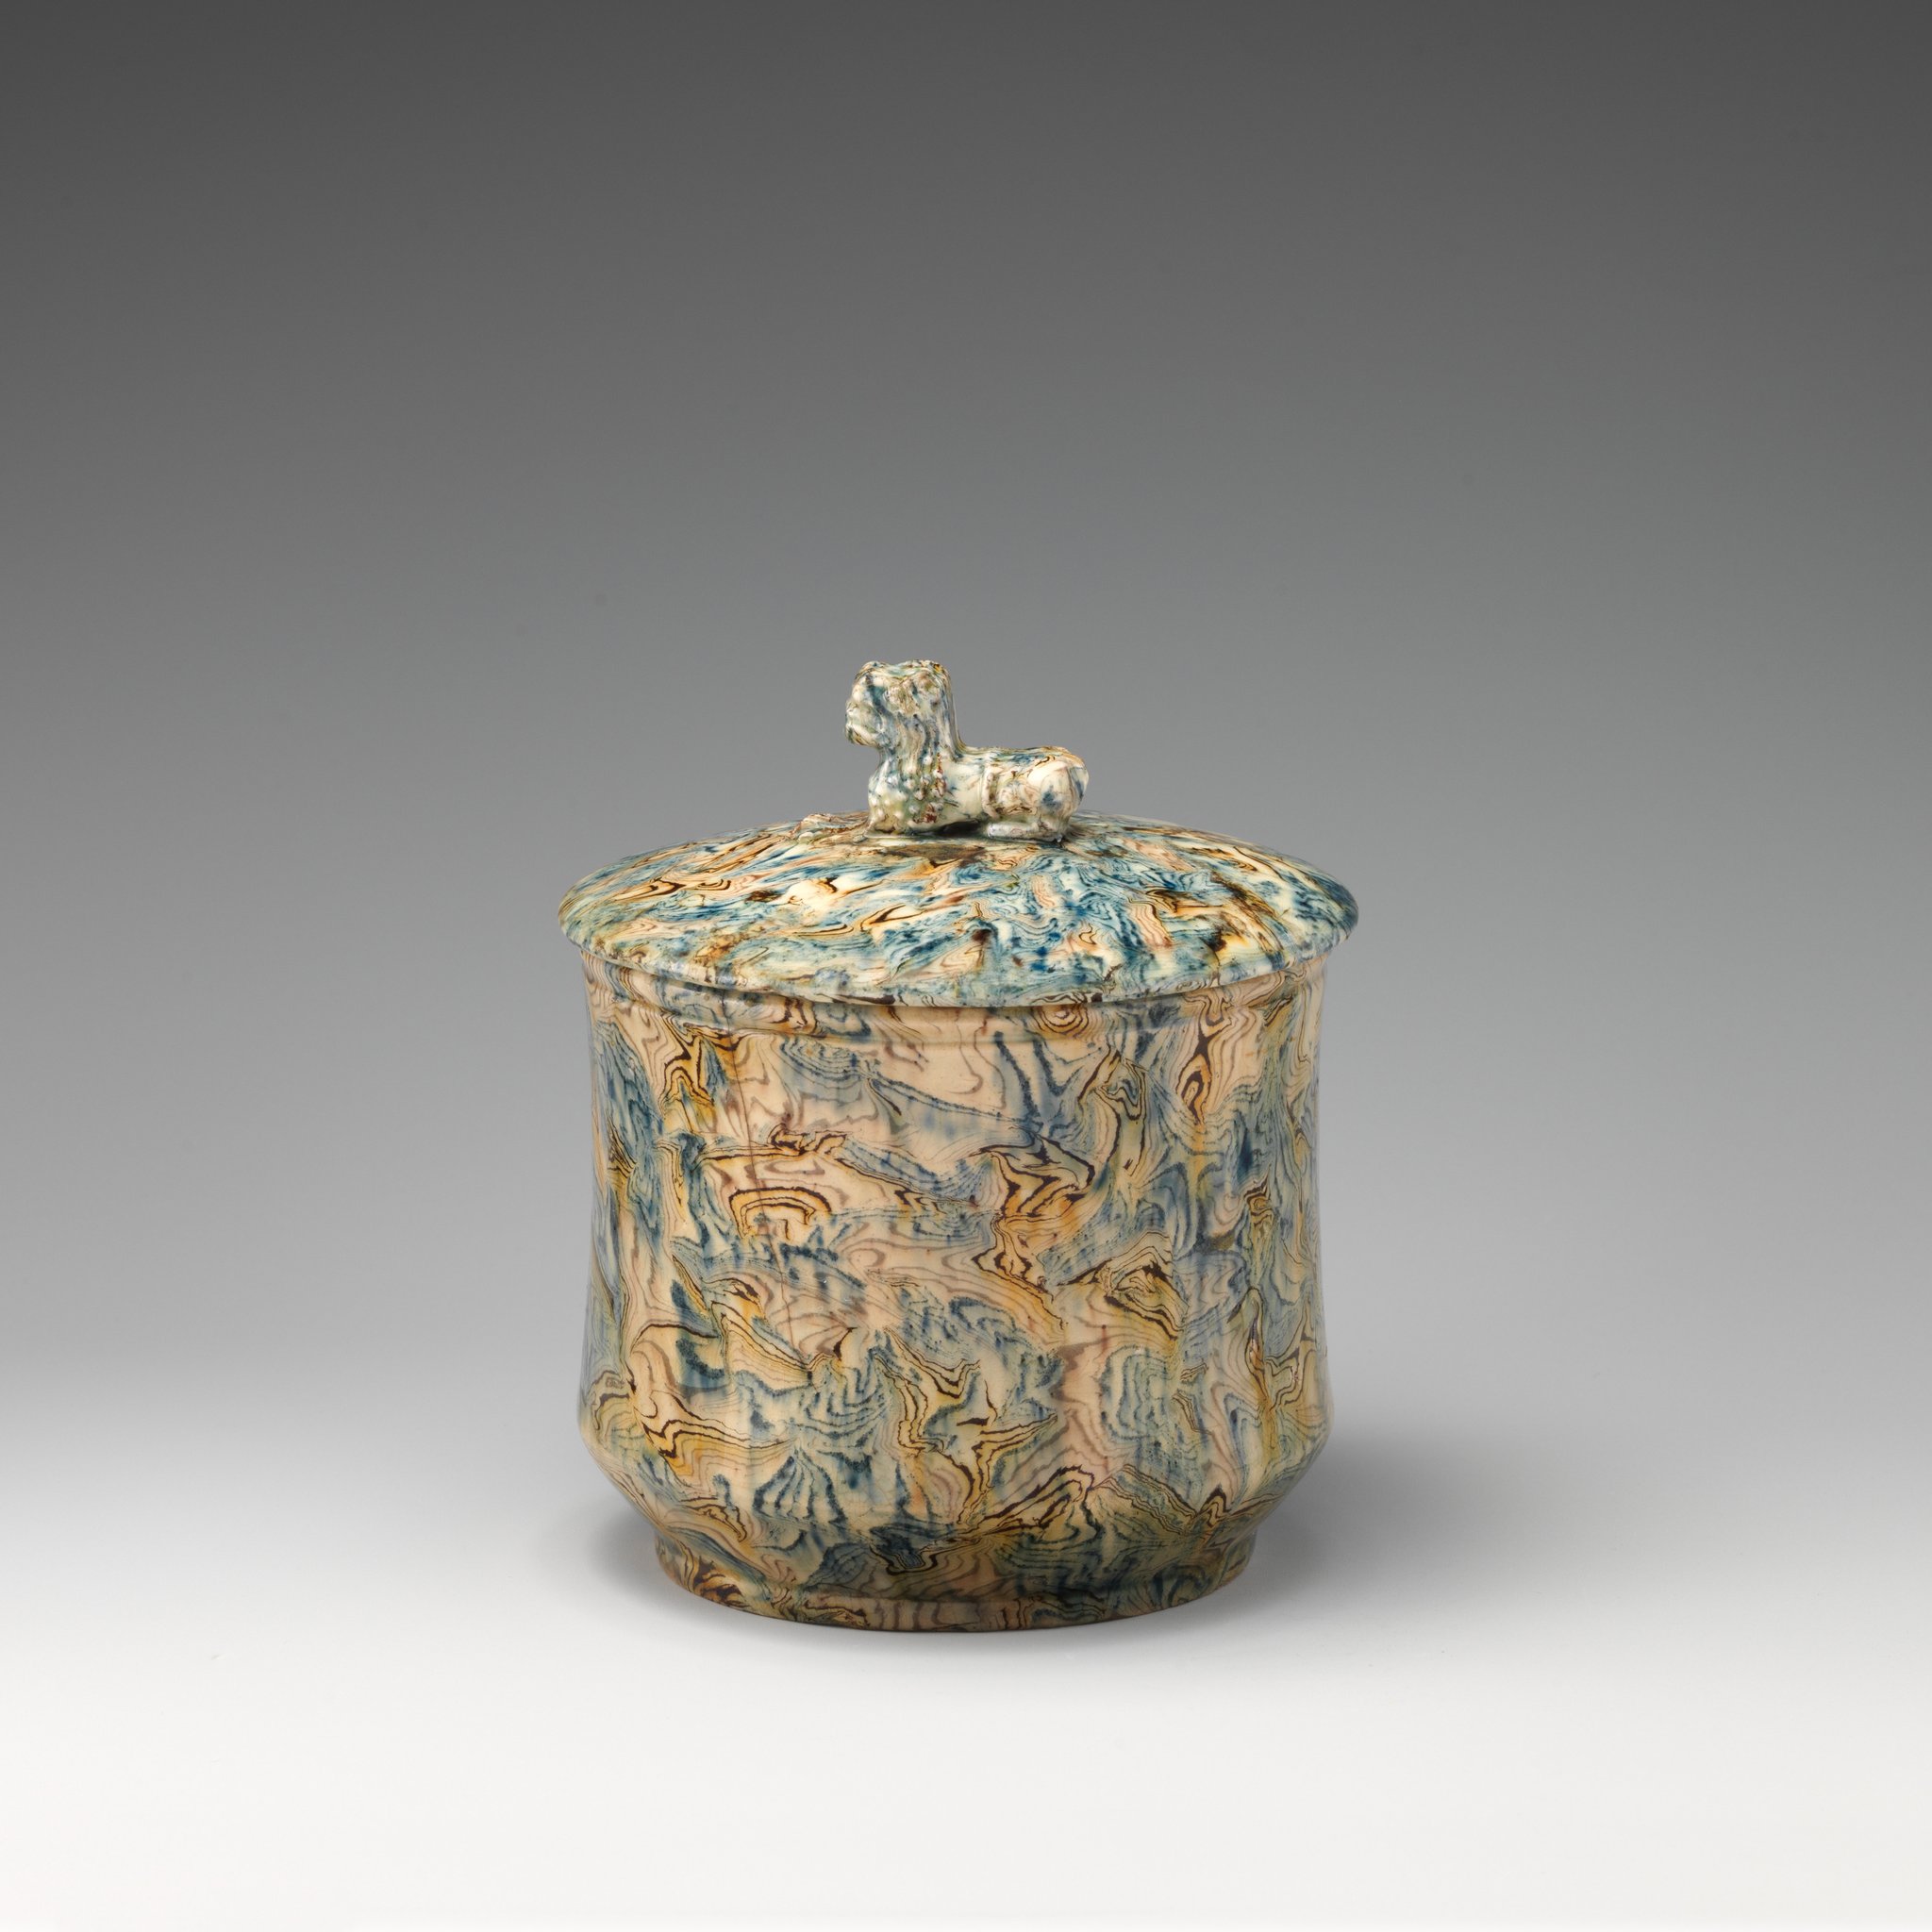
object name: bowl with cover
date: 1745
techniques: glazing